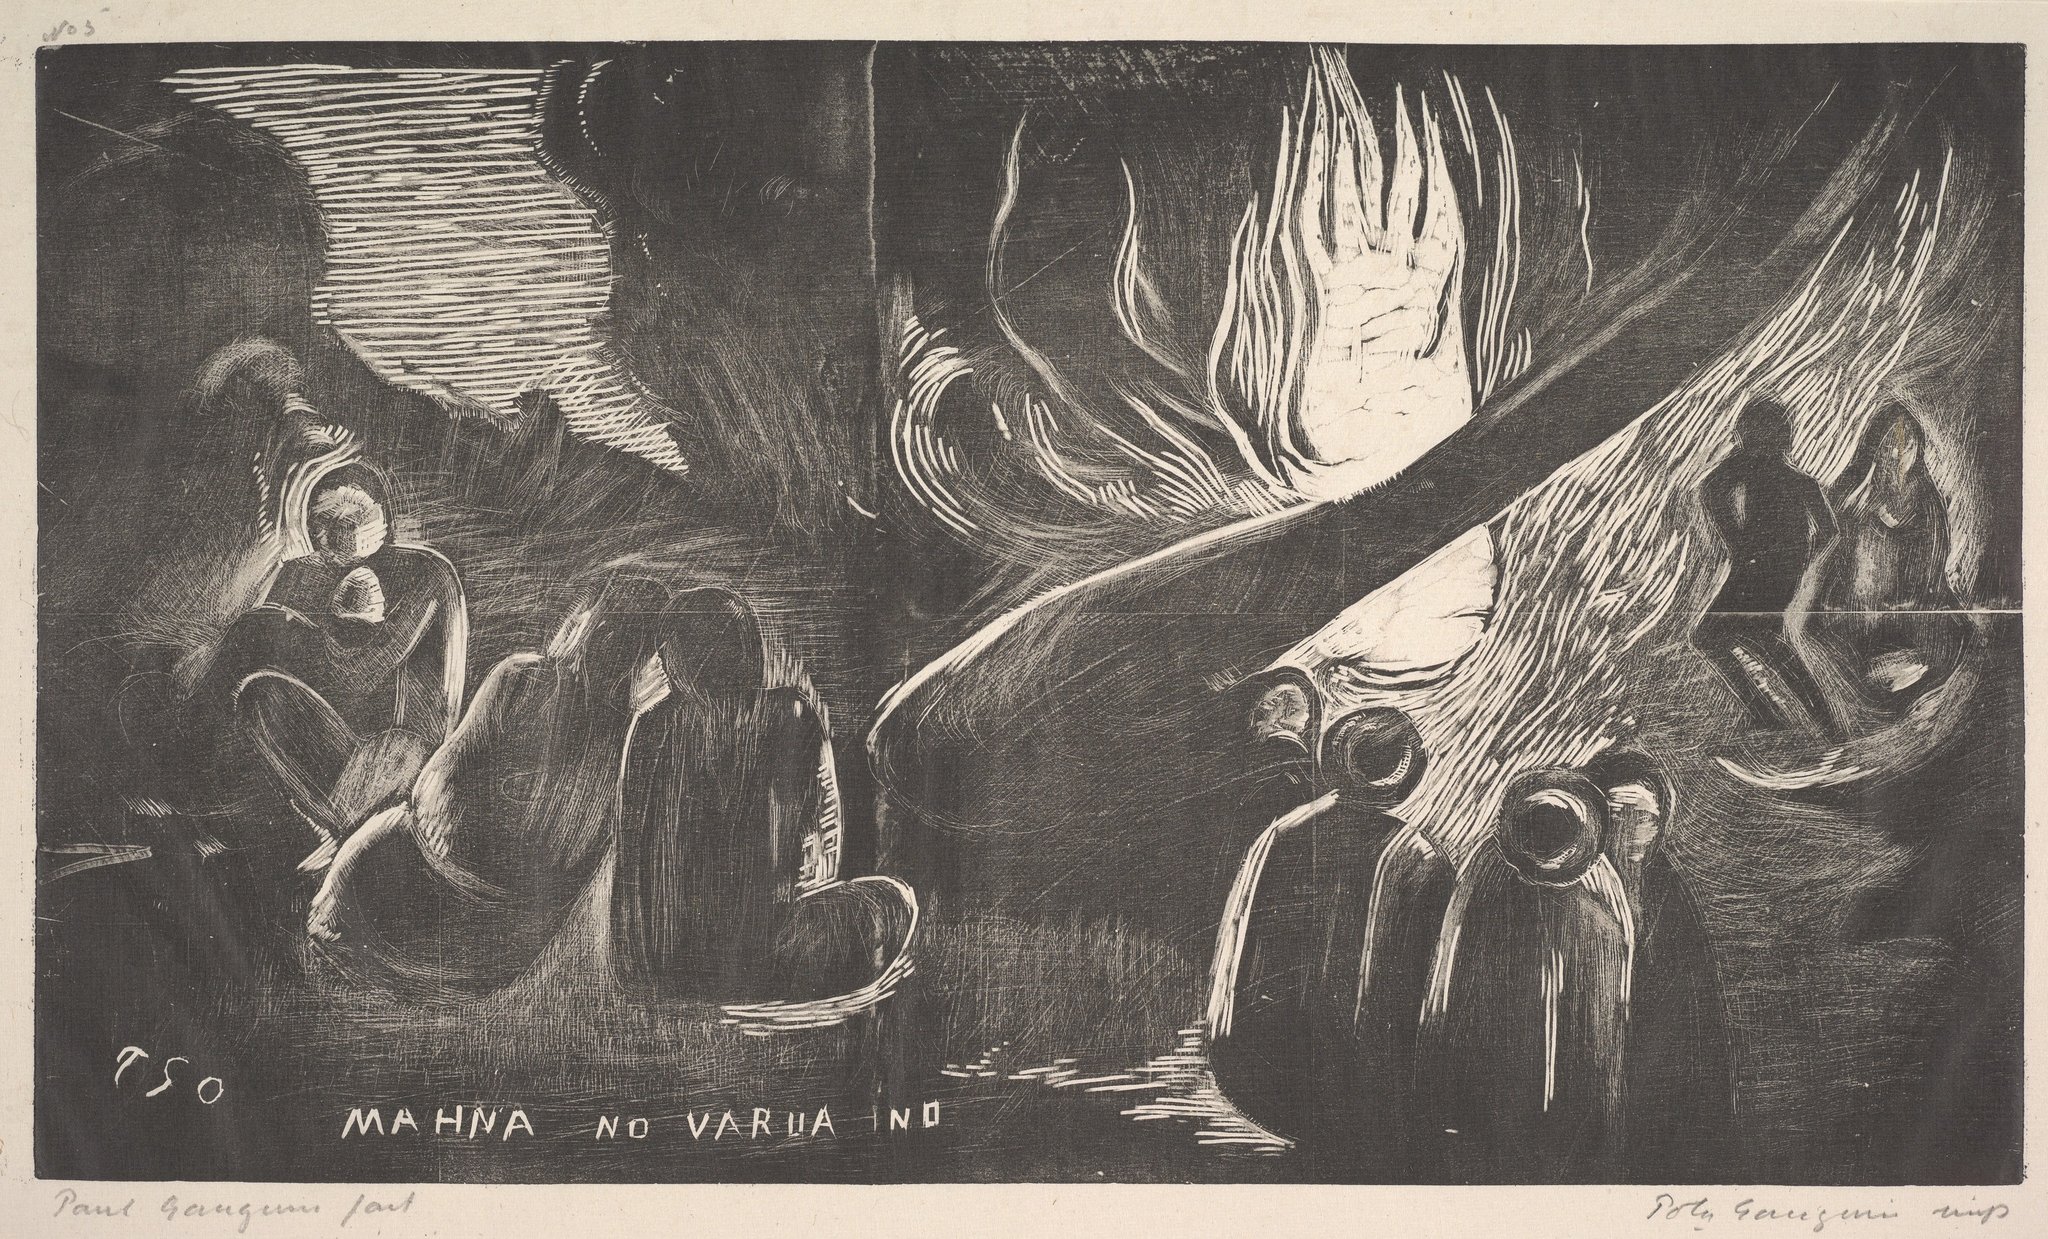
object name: print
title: The Devil Speaks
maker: paul gauguin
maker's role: artist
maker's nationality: french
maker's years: 1848-1903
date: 1893-1894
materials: paper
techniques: woodcut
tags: human figures